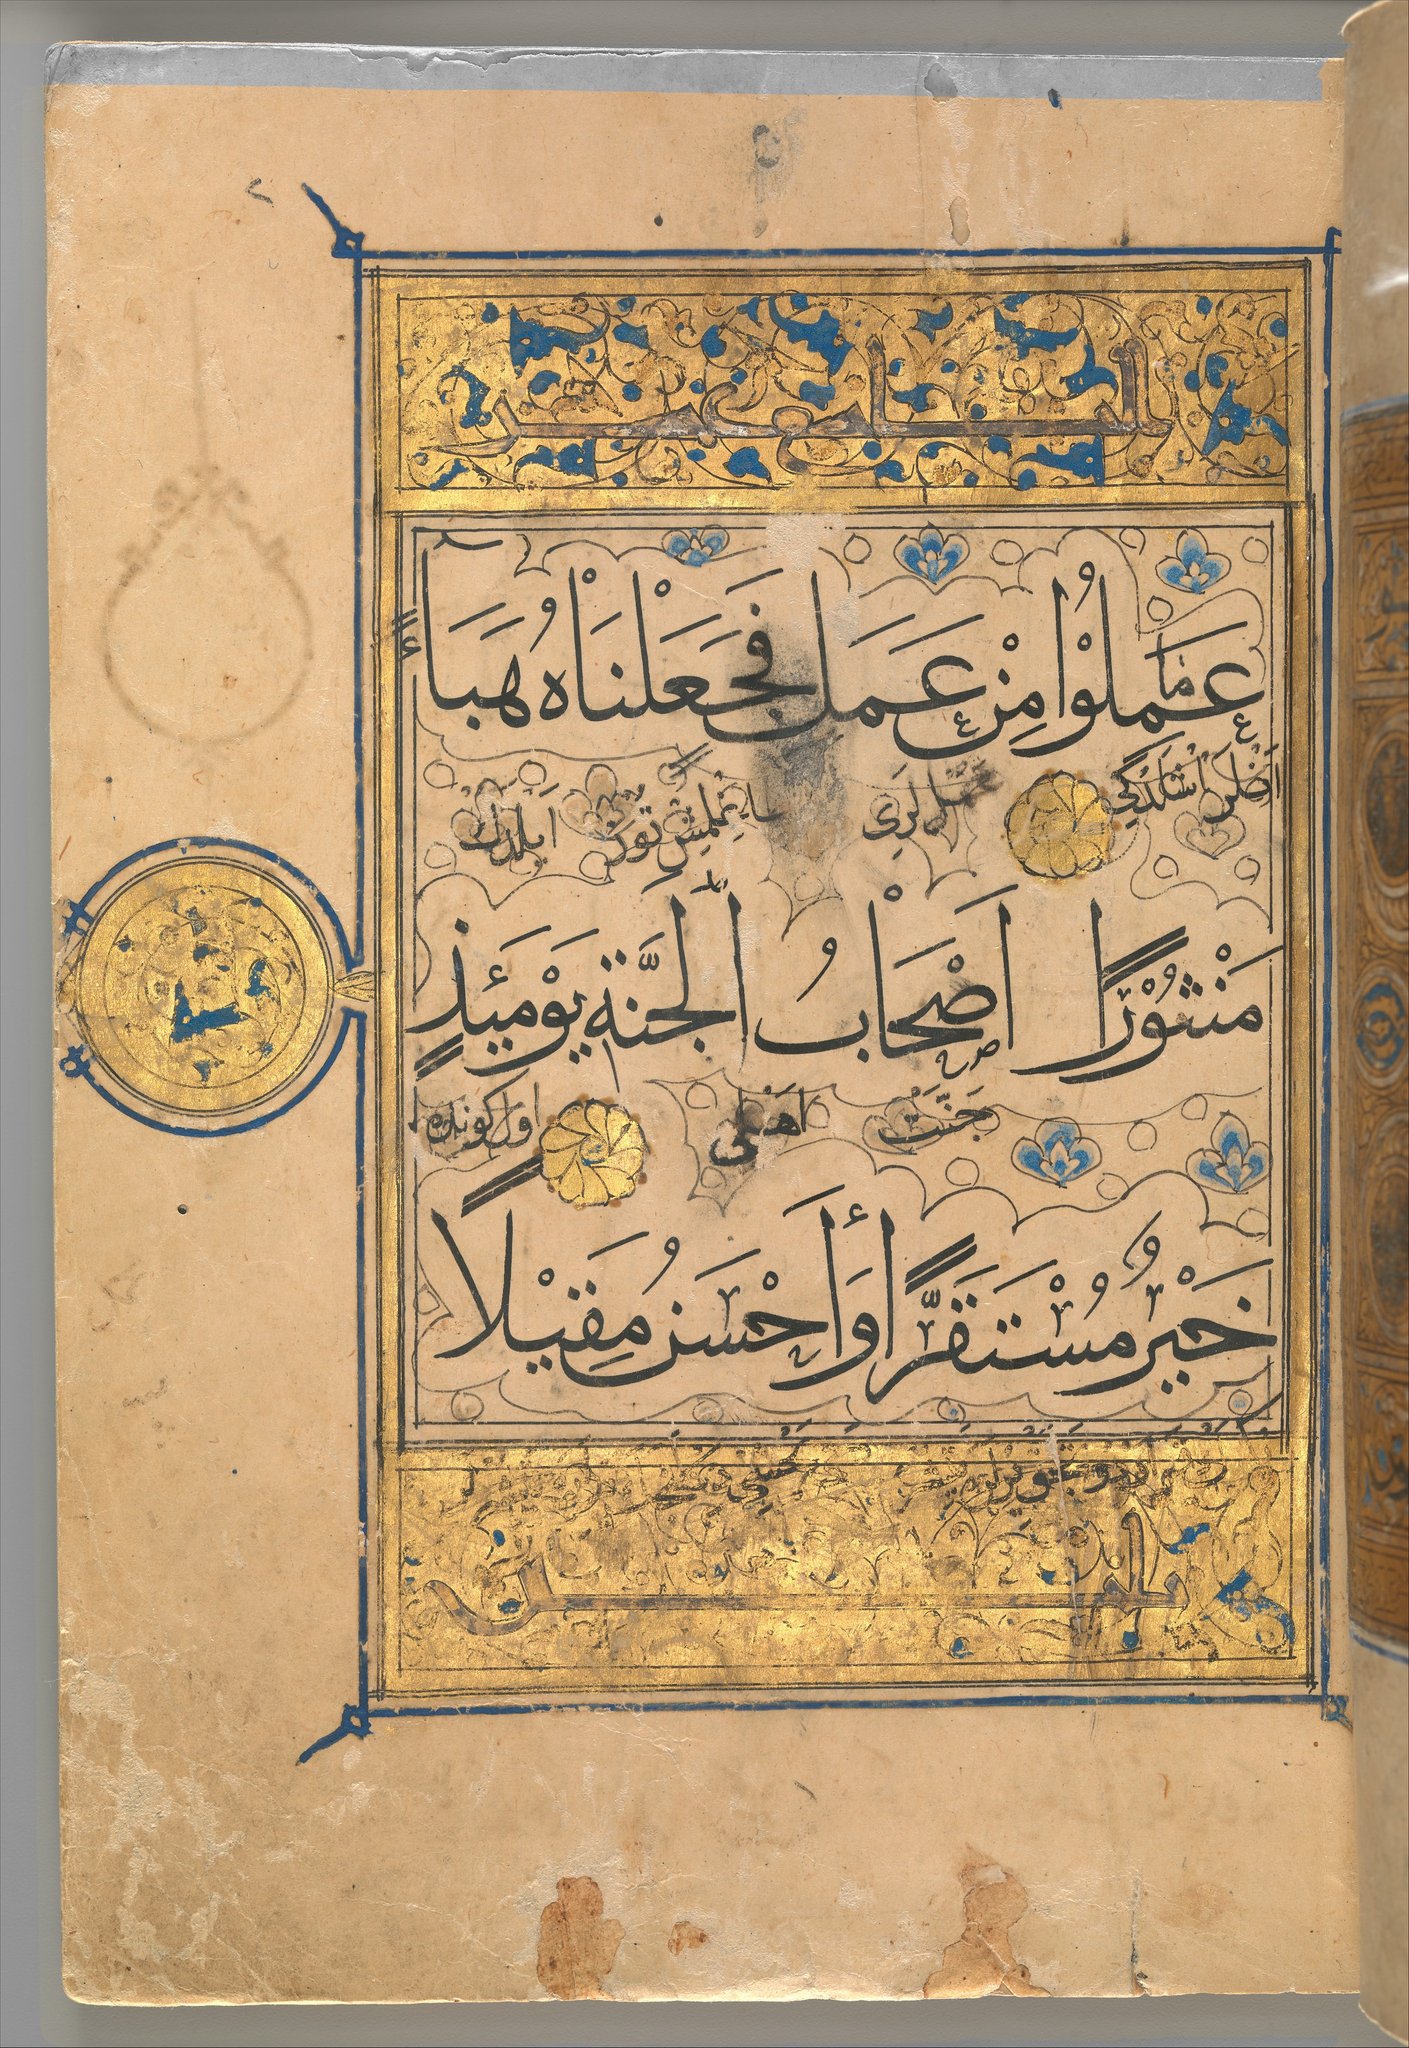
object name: section from a non illustrated manuscript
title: Section from a Qur'an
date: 1251-1300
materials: gold, ink, leather, paper, watercolor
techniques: bookbinding, tooling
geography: turkey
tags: qur'an